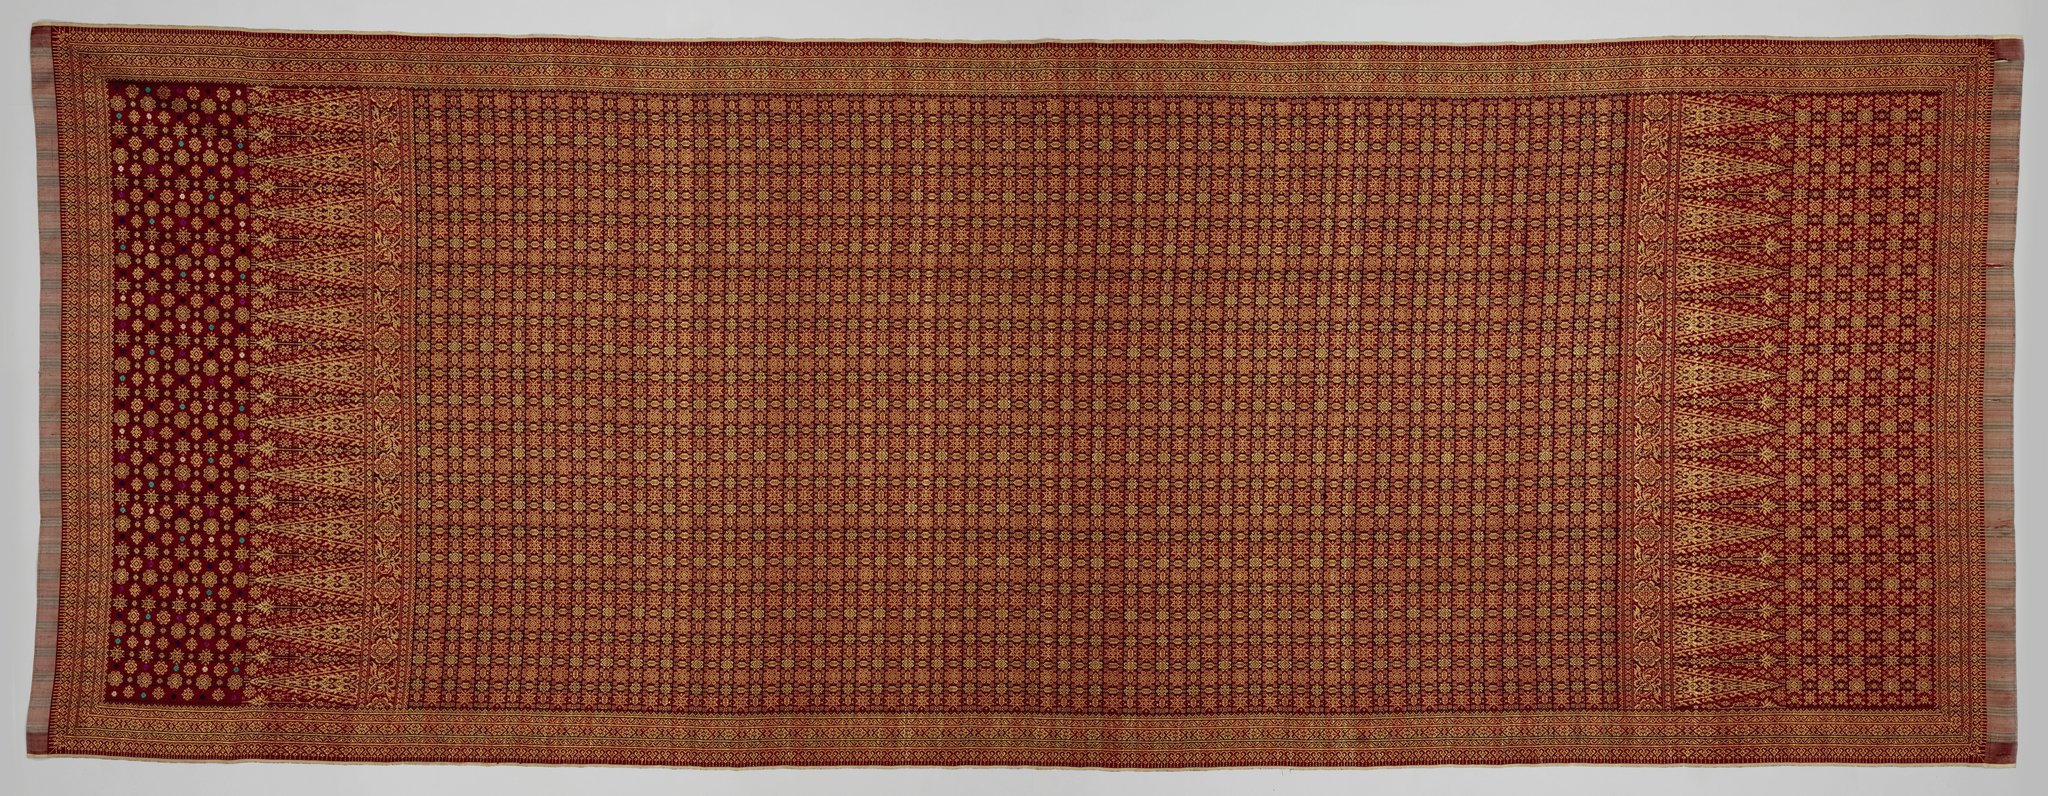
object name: cloth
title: Doek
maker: Anonymous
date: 1900-1999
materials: gold thread, silk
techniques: weave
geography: sumatra